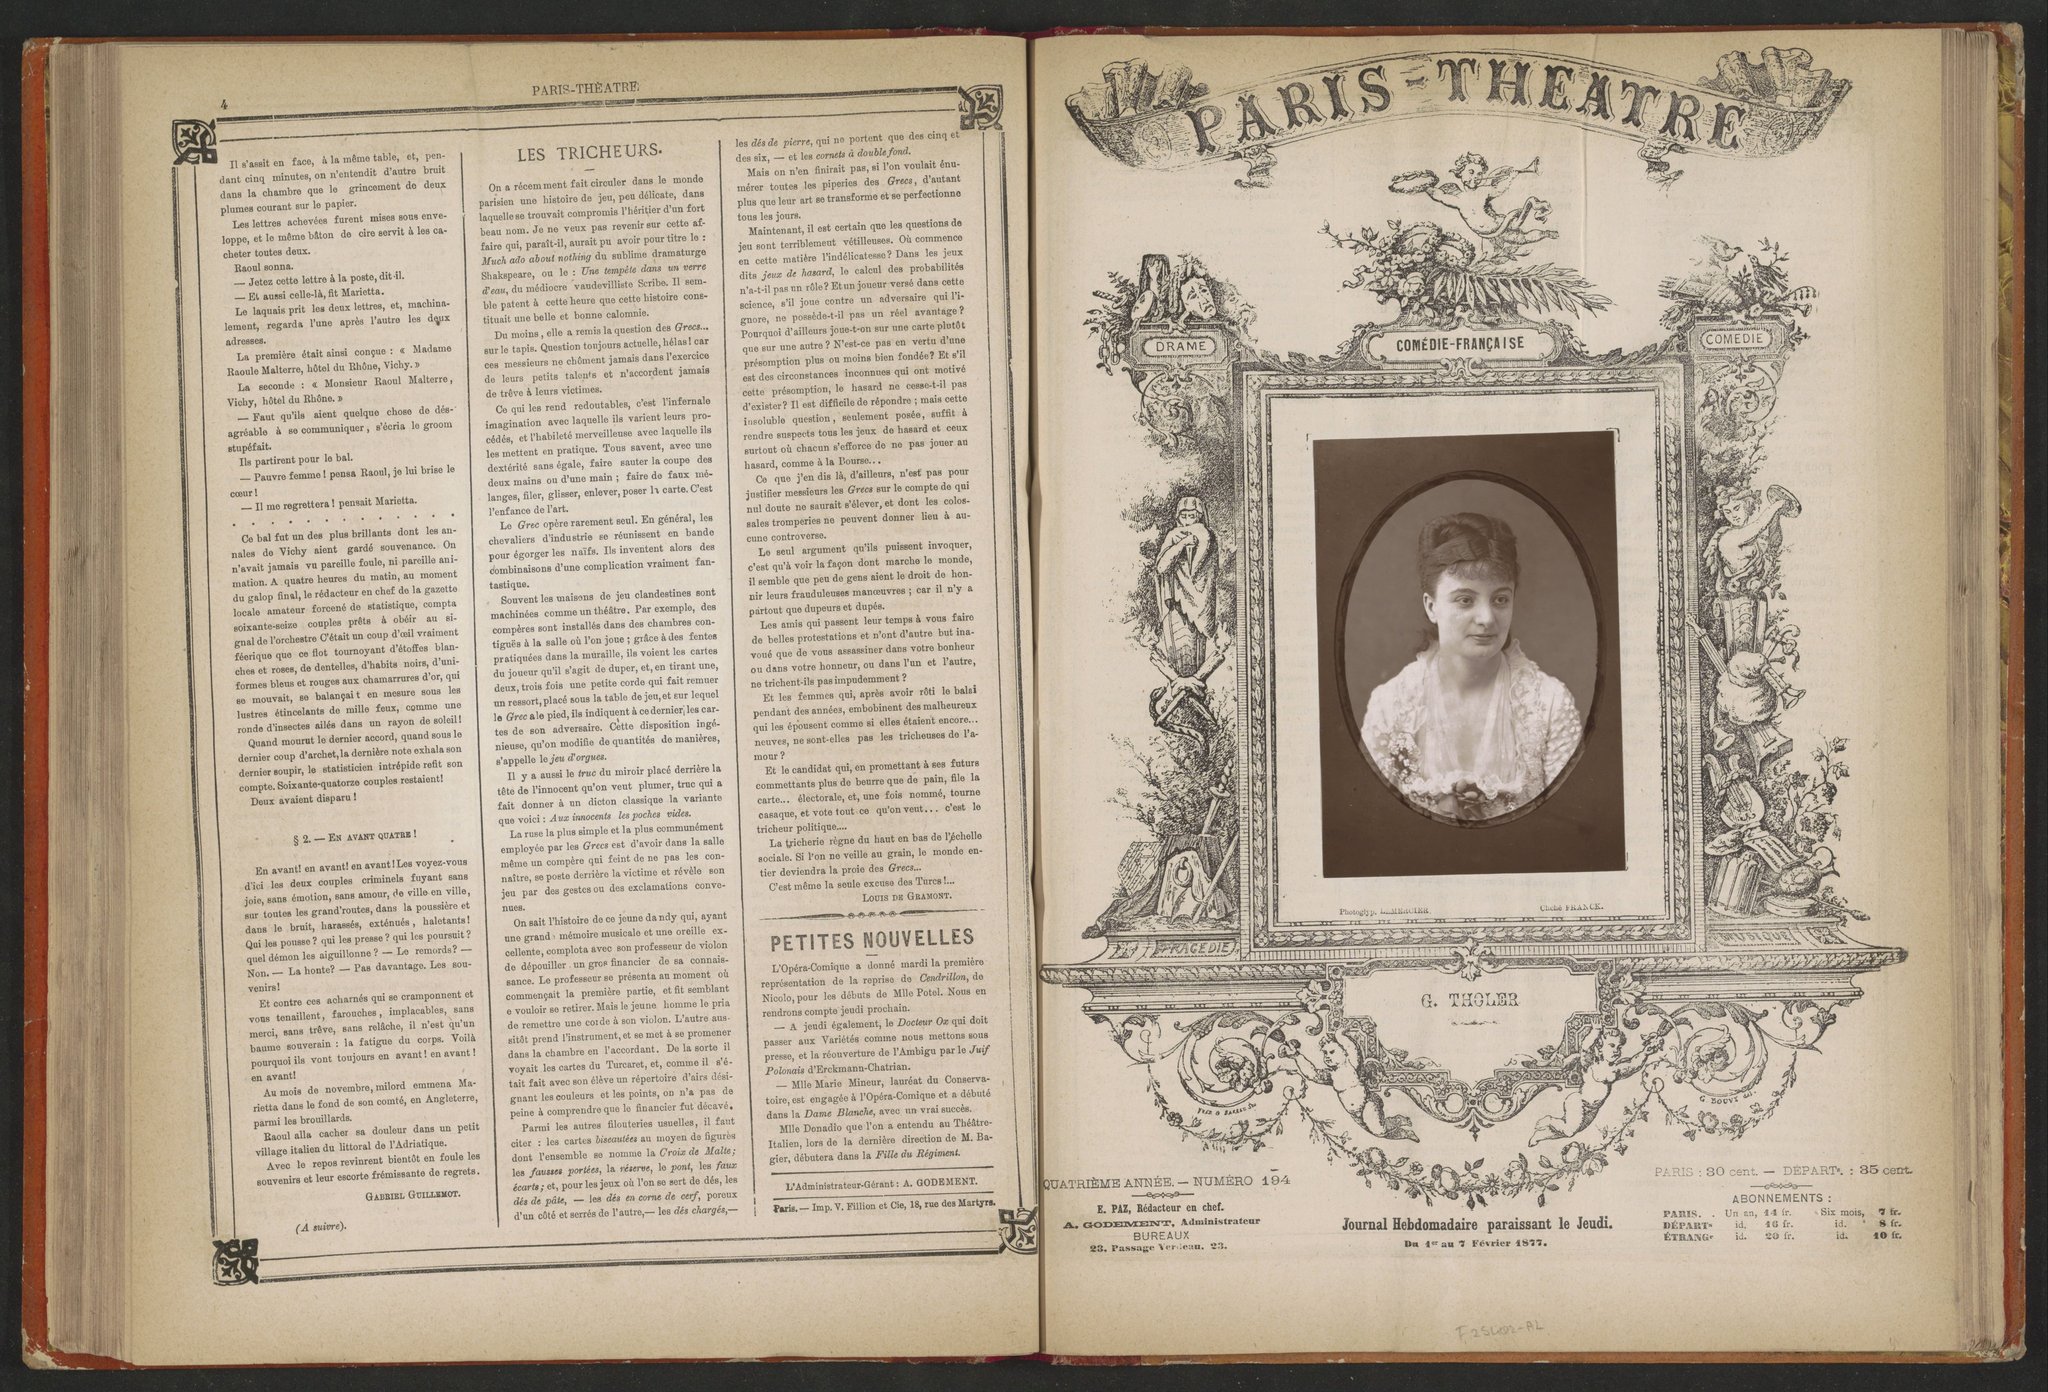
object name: photomechanical print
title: G. Tholer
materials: paper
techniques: woodburytype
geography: paris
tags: portrait of actor, actress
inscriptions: number: ‘Numéro 194’, inscription: ‘Journal Hebdomadaire paraissant le Jeudi, Du 1er au 7 Février 1877.’